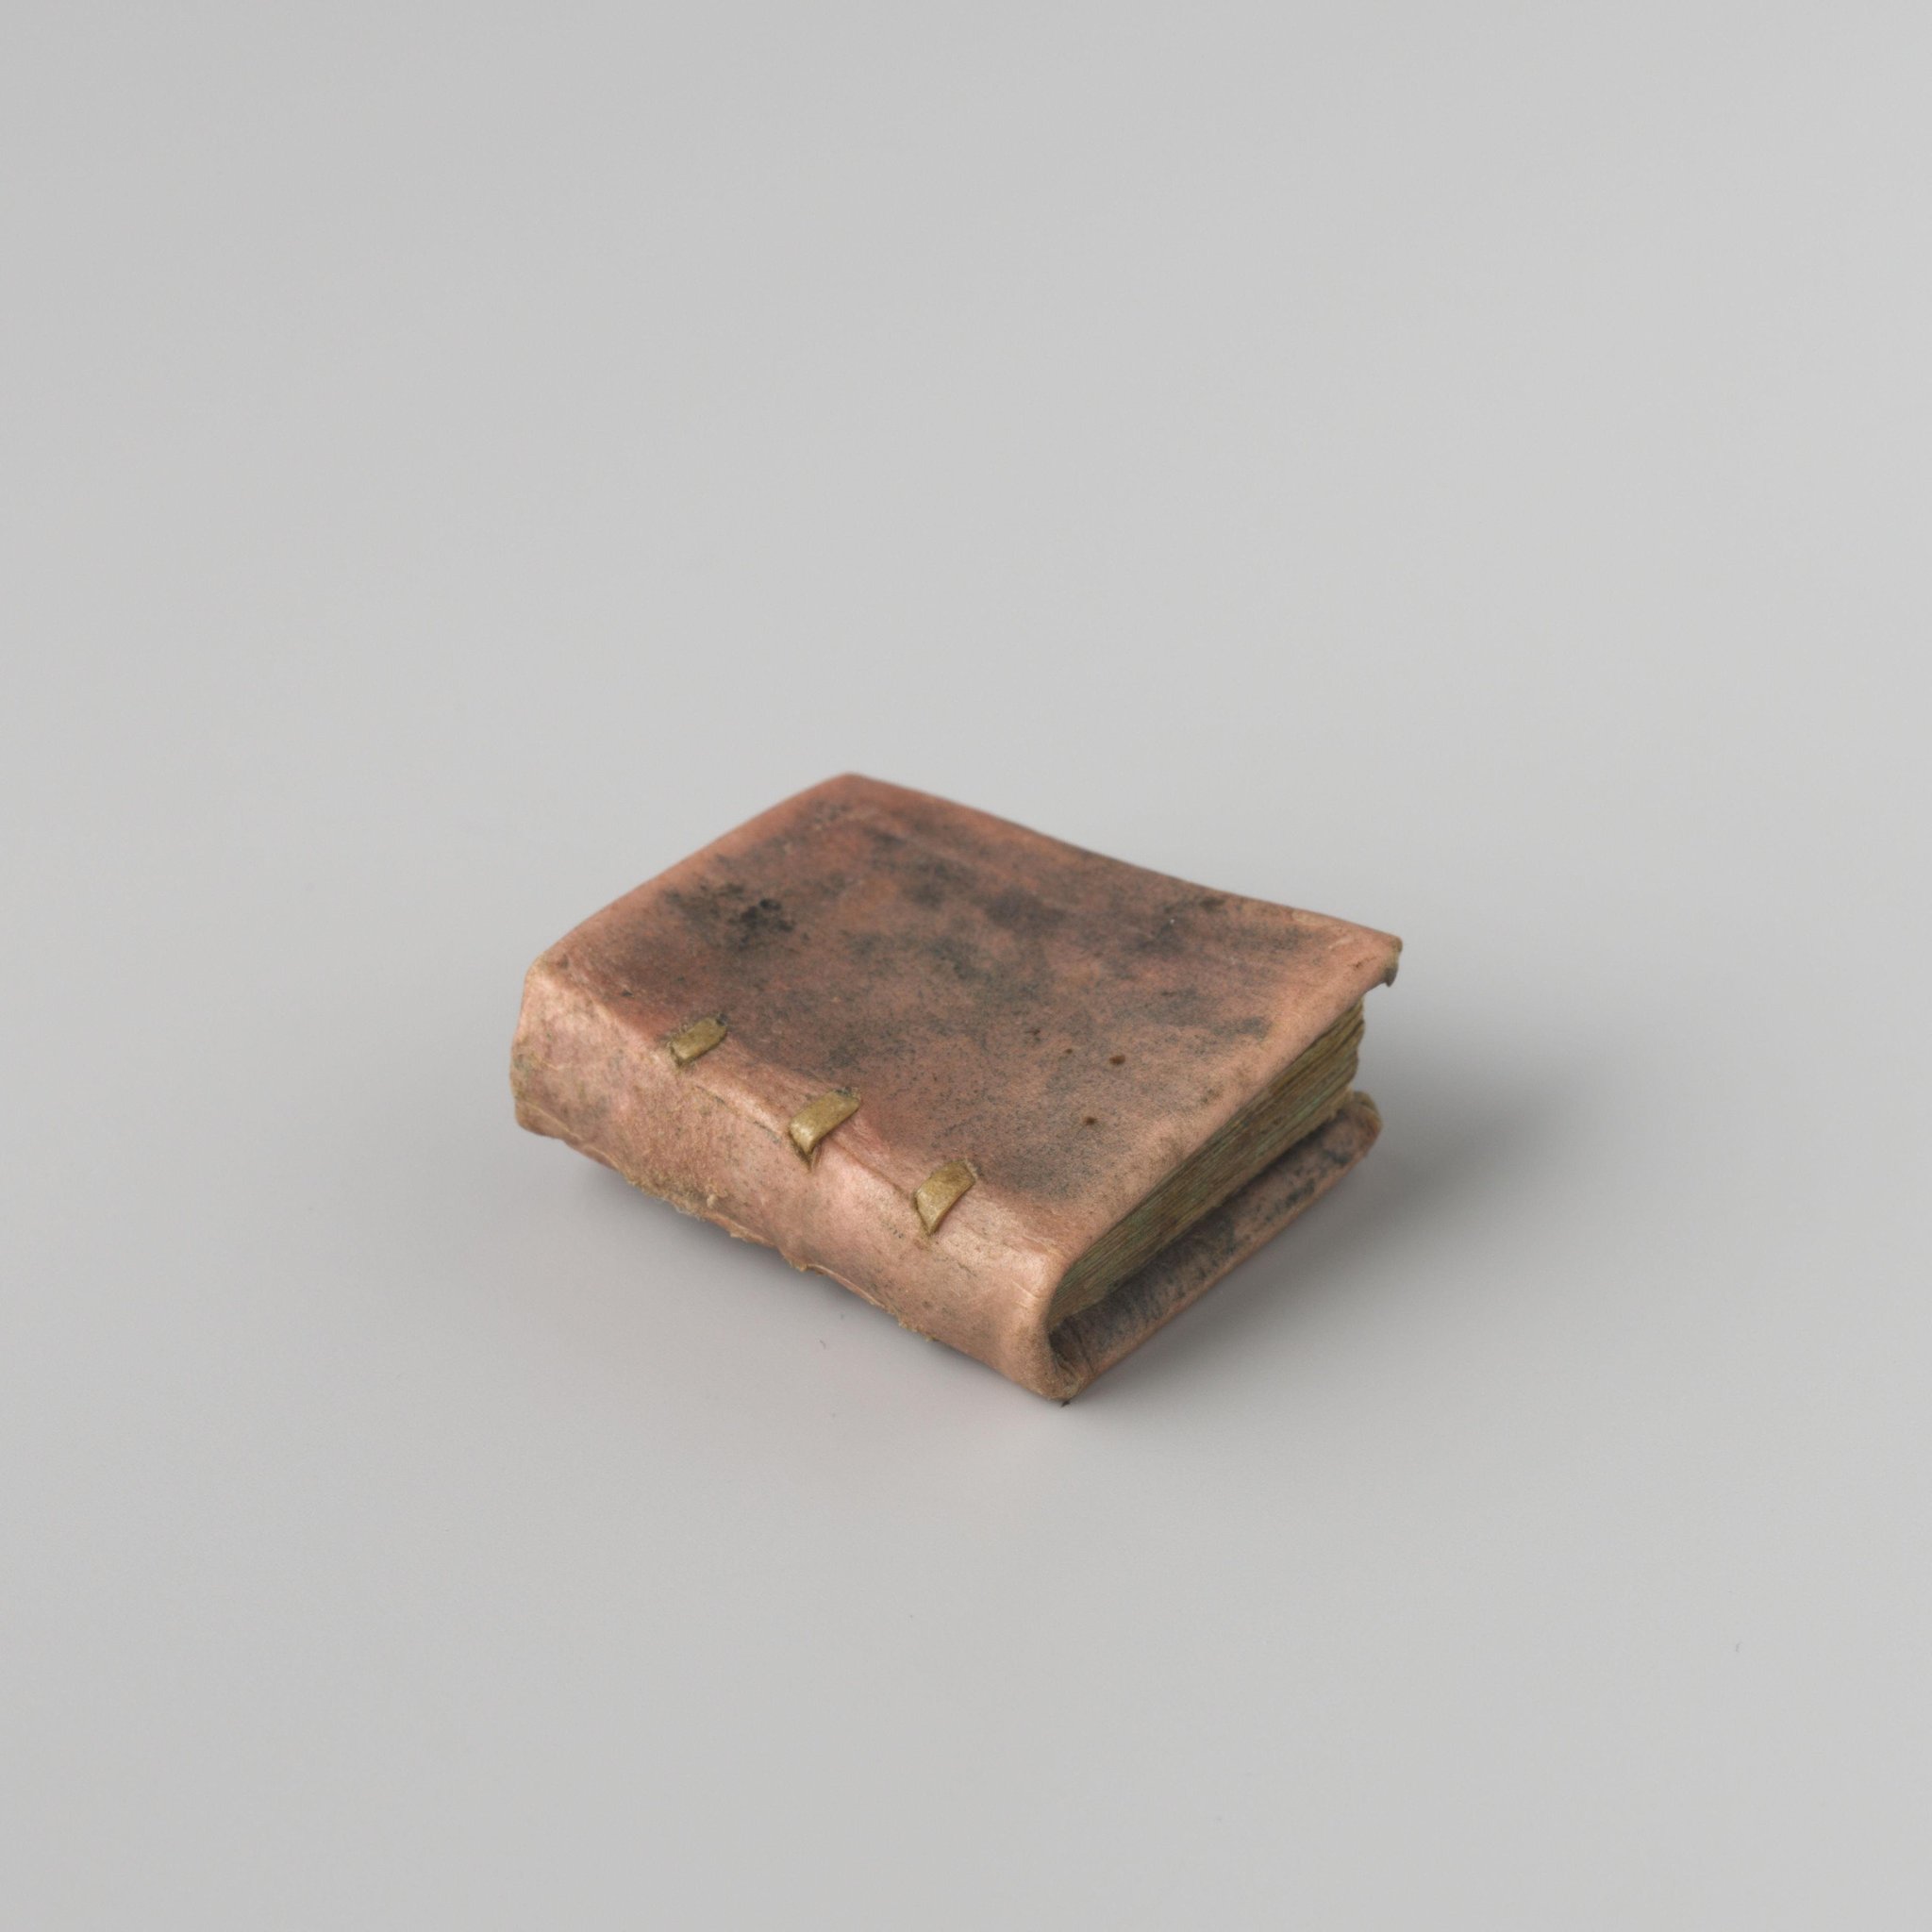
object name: book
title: Boek met stads- en tuingezichten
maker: Anonymous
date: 1690-1710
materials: paper, parchment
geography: amsterdam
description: Boek met stads- en tuingezichten. Ingebonden in roze-blauw gekleurd perkament.